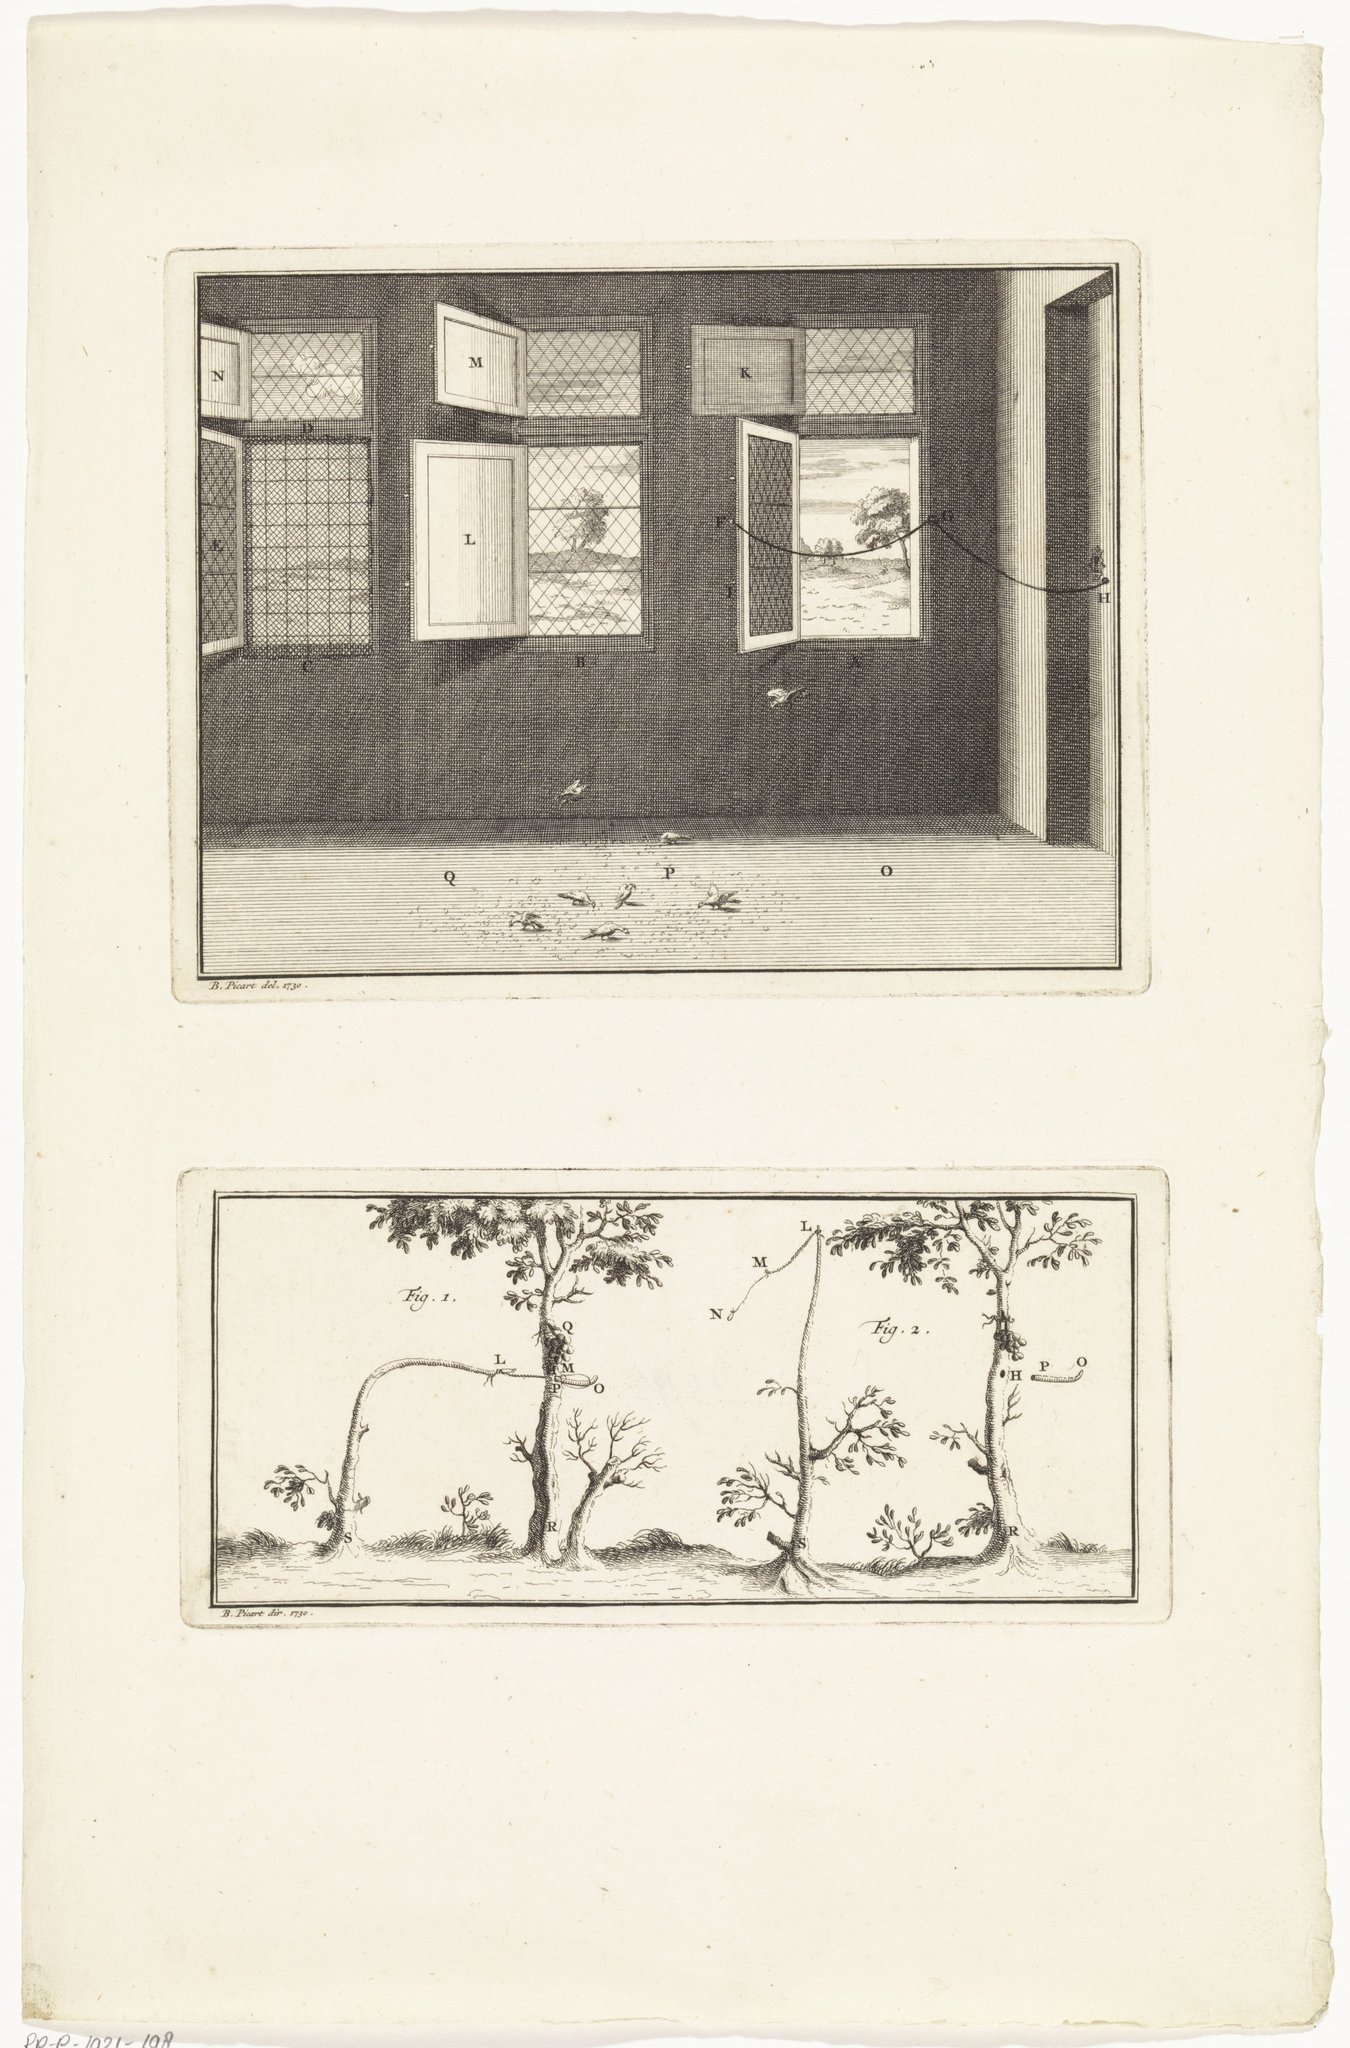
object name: print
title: Vogelval in huis en vogelval in de struiken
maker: bernard picart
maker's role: draughtsman, print maker, publisher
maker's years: 1673-1733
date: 1730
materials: paper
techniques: etching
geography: amsterdam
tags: catching animals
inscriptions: collector's mark: Lugt 2233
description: Prenten bedoeld voor: Chomel, Noel. Dictionnaire oeconomique, contenant divers moïens d'augmenter son bien, et de conserver sa santé. Amsterdam: Johannes Covens en Cornelis Mortier, 1732.